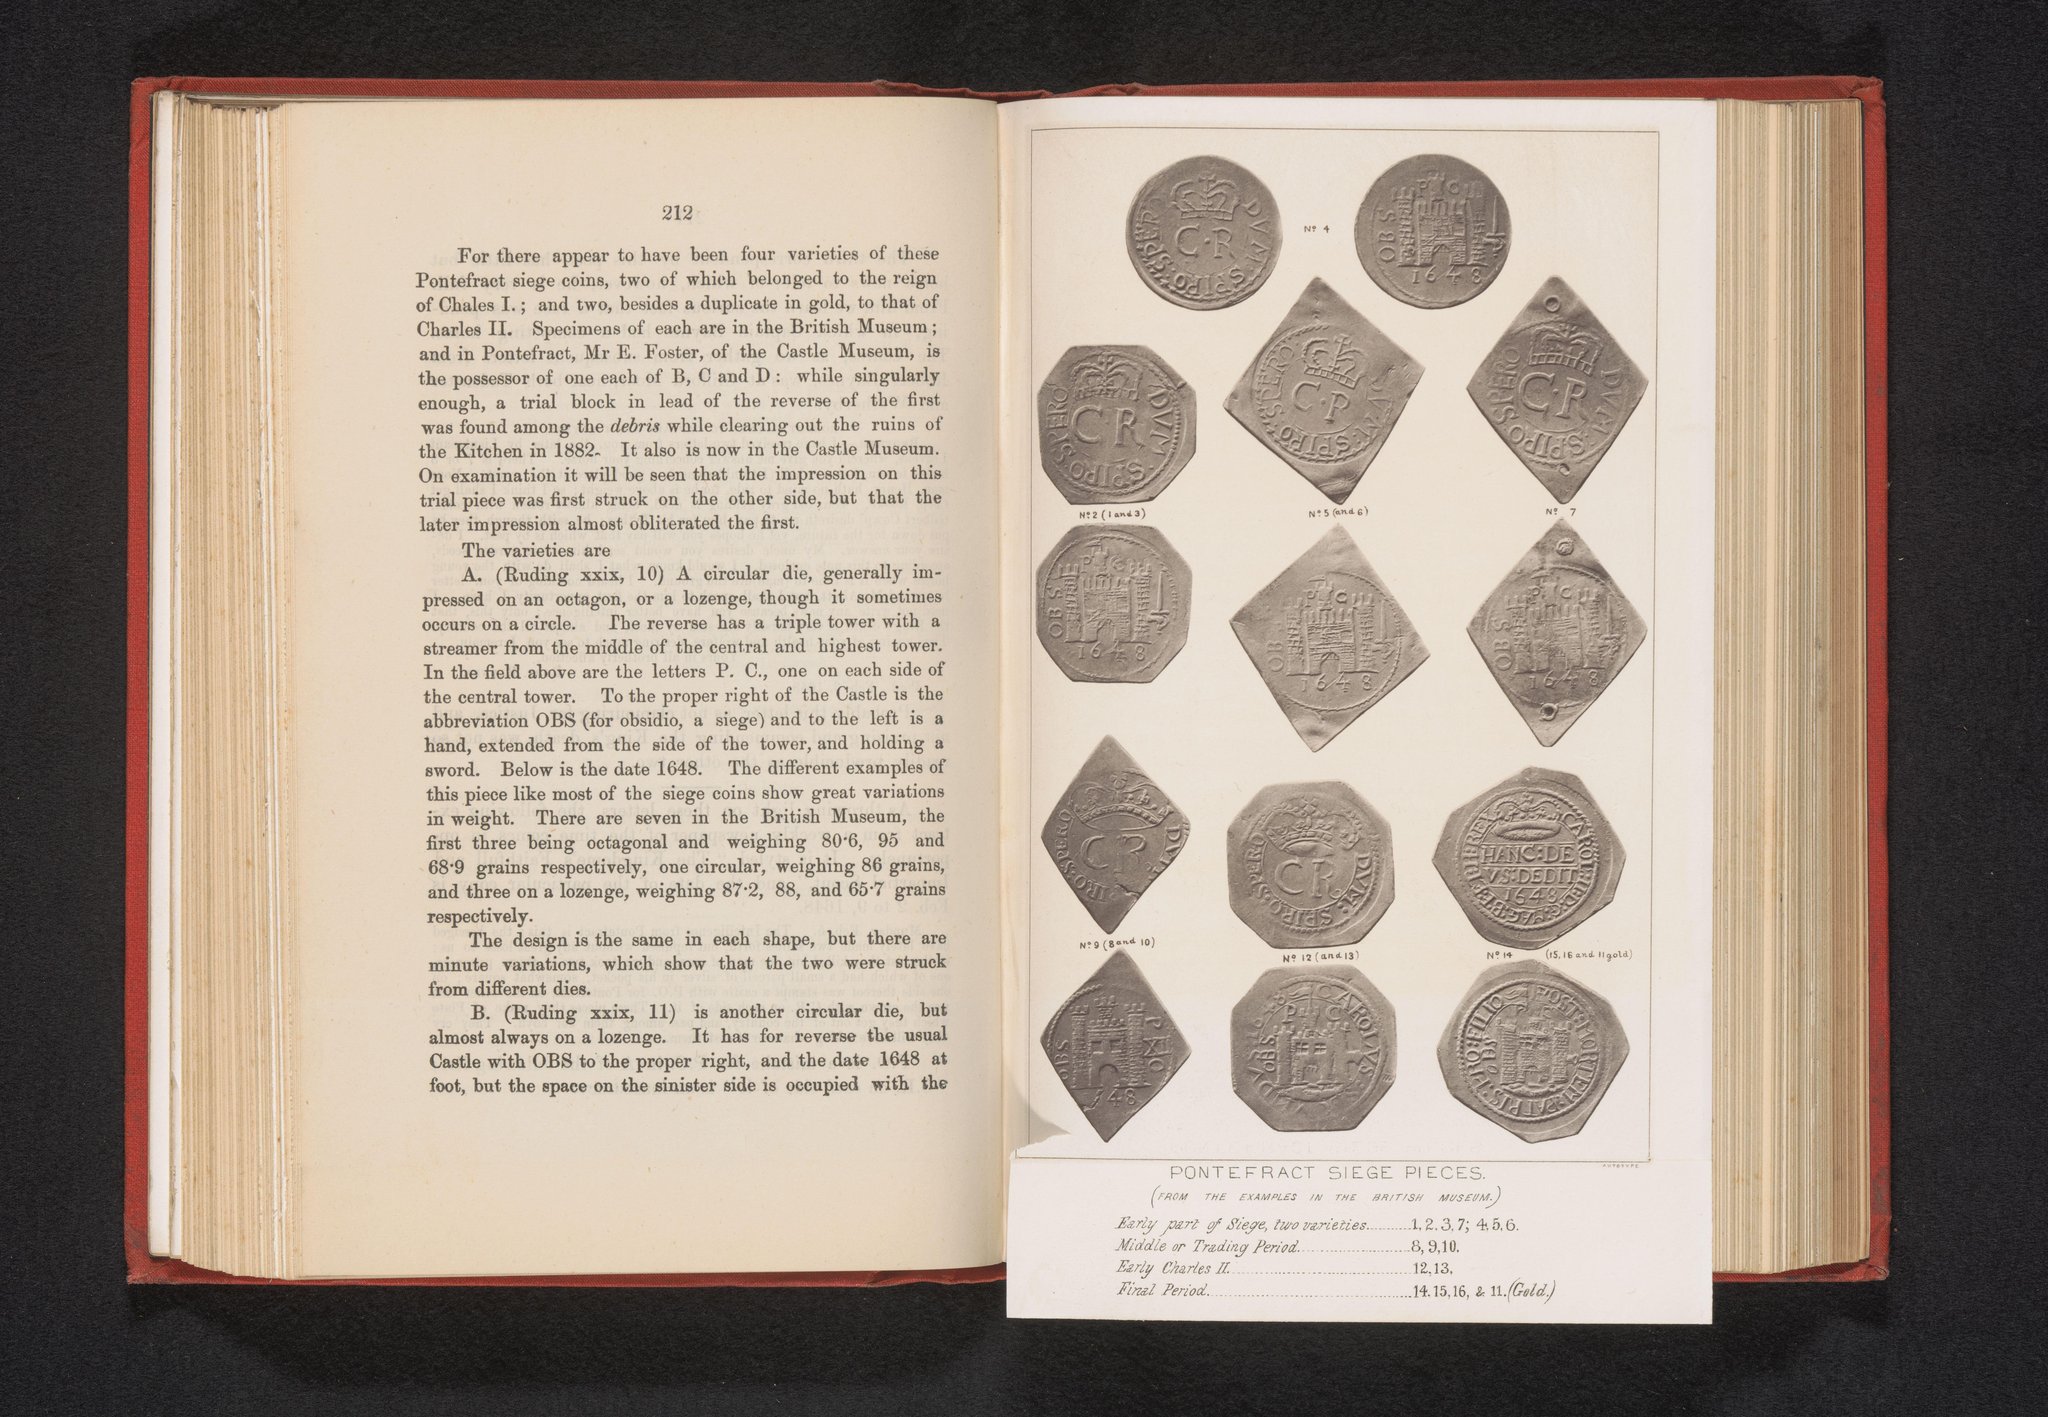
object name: photomechanical print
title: Veertien munten uit het Beleg van Pontefract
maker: Anonymous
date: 1882-1887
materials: paper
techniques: photograph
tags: coin, siege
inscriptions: inscription: ‘(From the examples in the British Museum.)/ Early part of Siege, two varieties. 1,2,3,7; 4,5,6./ Middle or Trading Period. 8,9,10./ Early Charles II. 12,13./ Final Period. 14.15,16, & 11. (Gold.)’